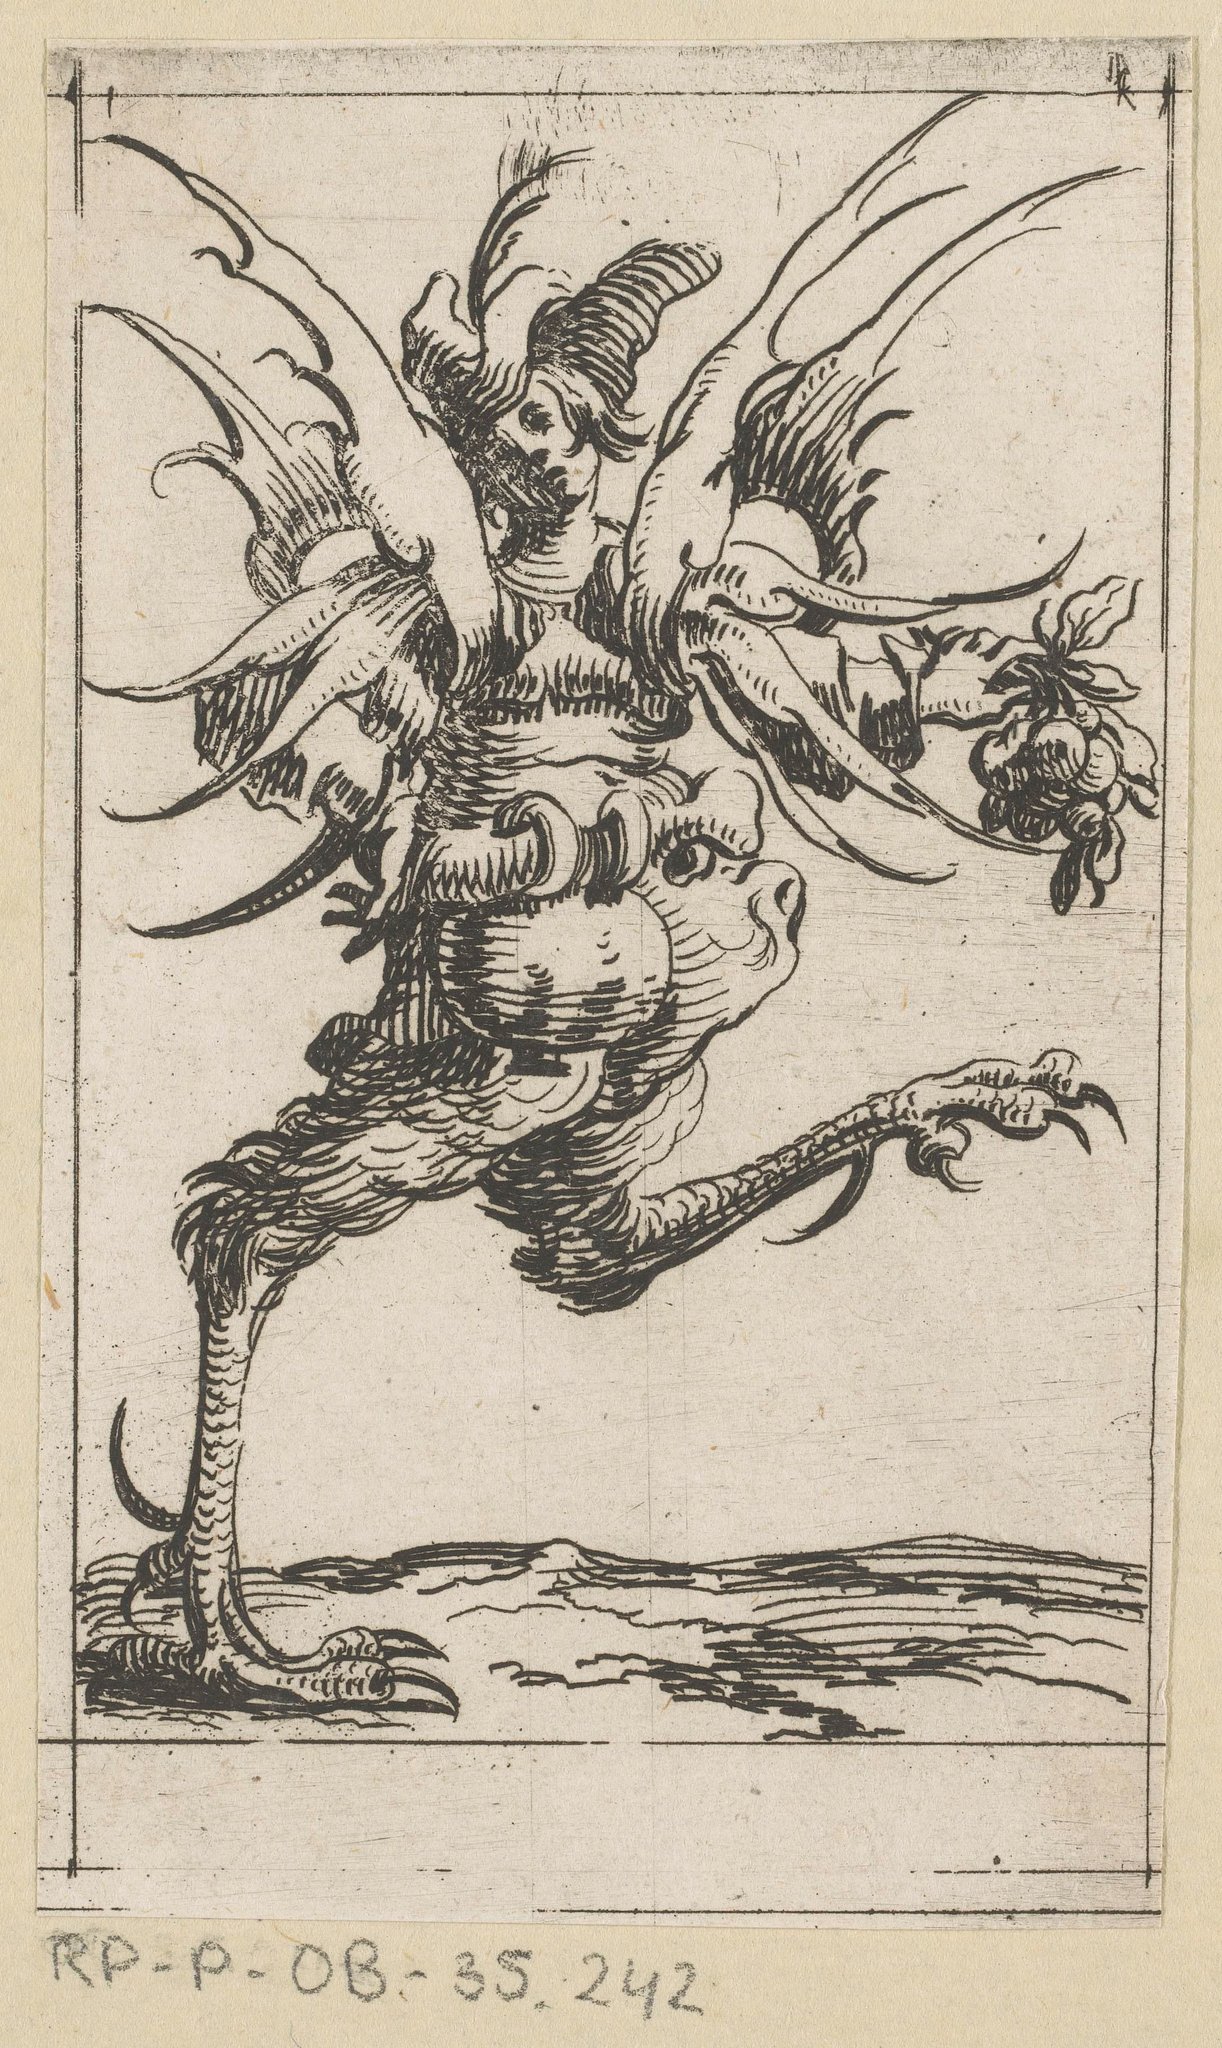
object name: ornament print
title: Twaalf maanden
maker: denis boutemie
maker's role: print maker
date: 1633-1643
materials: paper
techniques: etching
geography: paris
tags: october; 'ottobre' (ripa)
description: Personificatie van de maand oktober. Een grotesk figuur met vleugels en vogelpoten. Hij draagt een hoed op zijn hoofd, een varkensmasker op zijn buik en fruit in zijn hand.